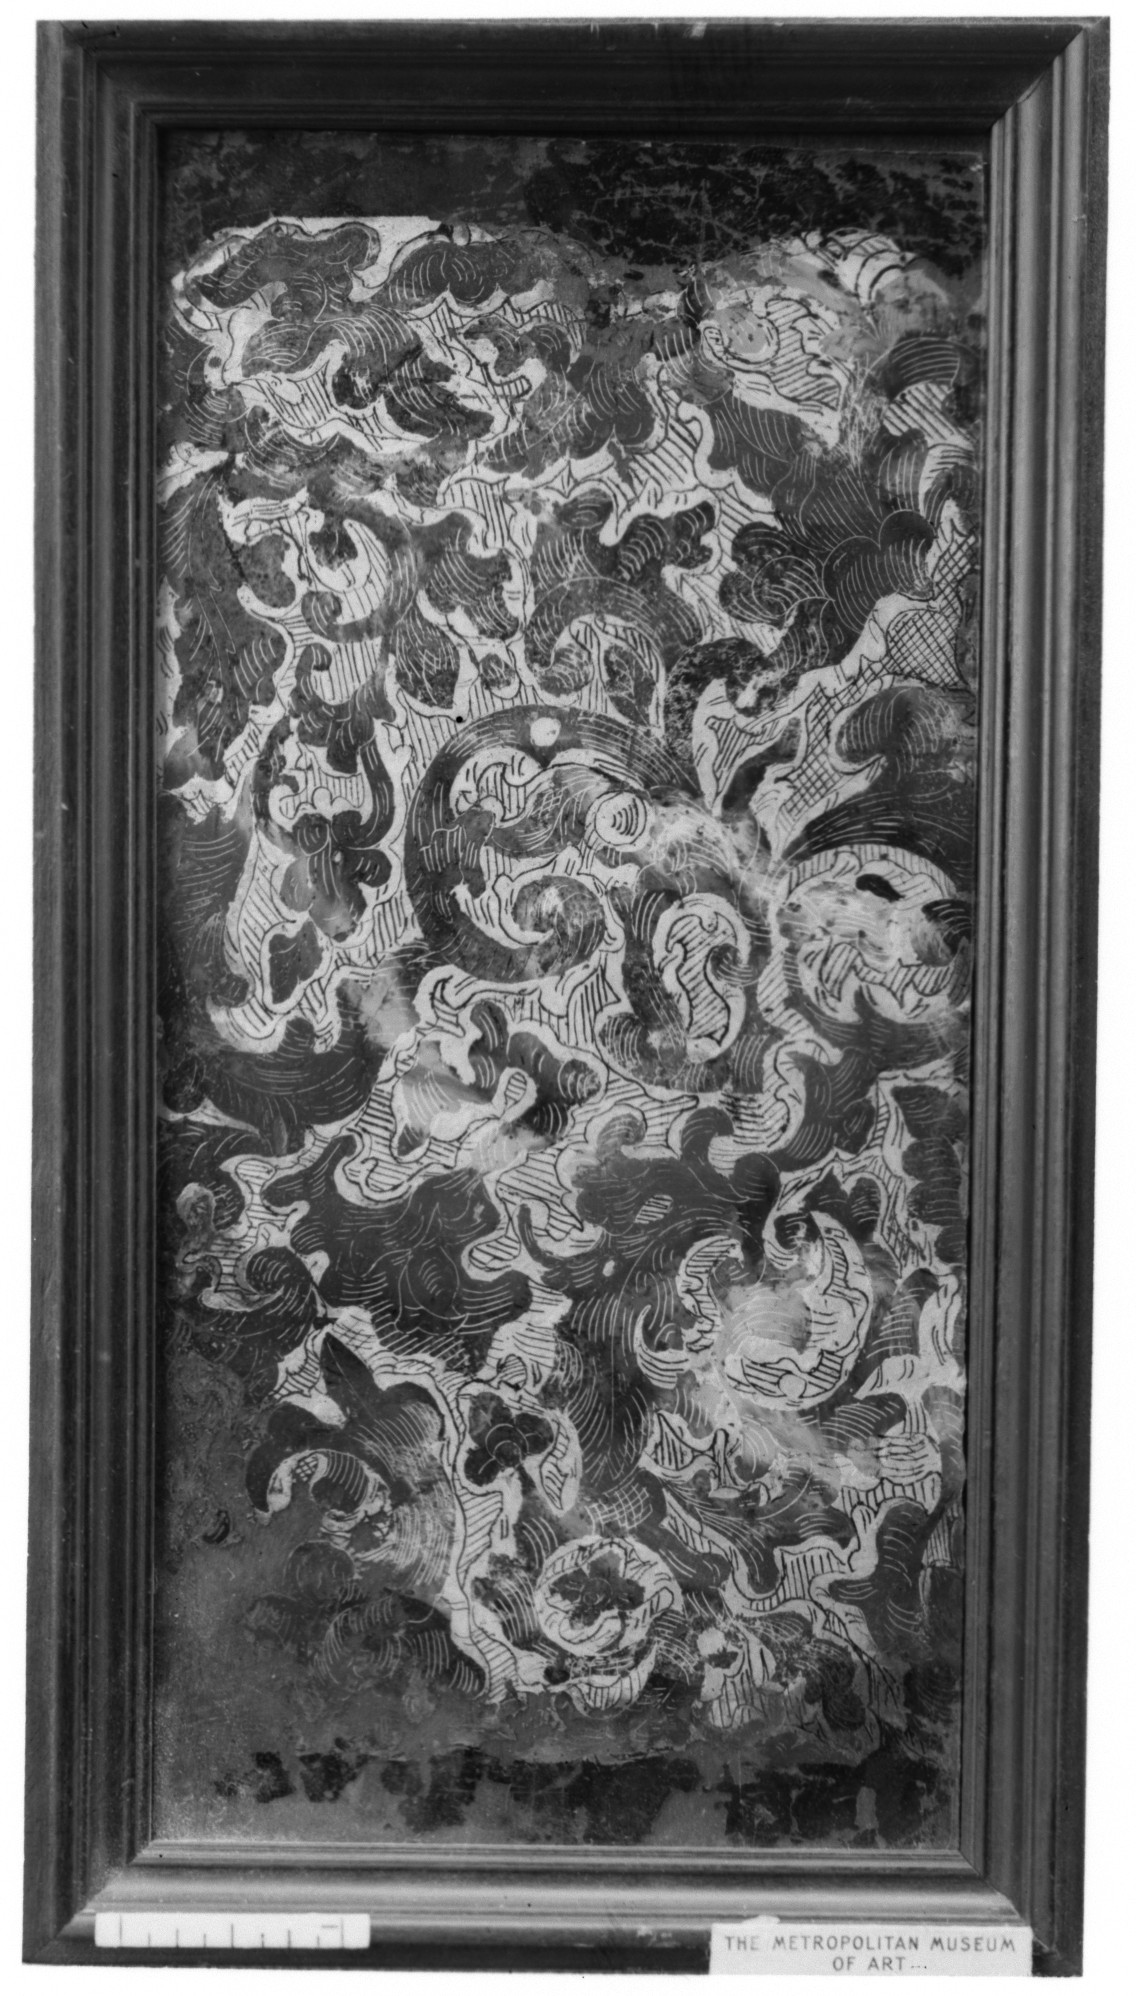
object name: panel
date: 1601-1700